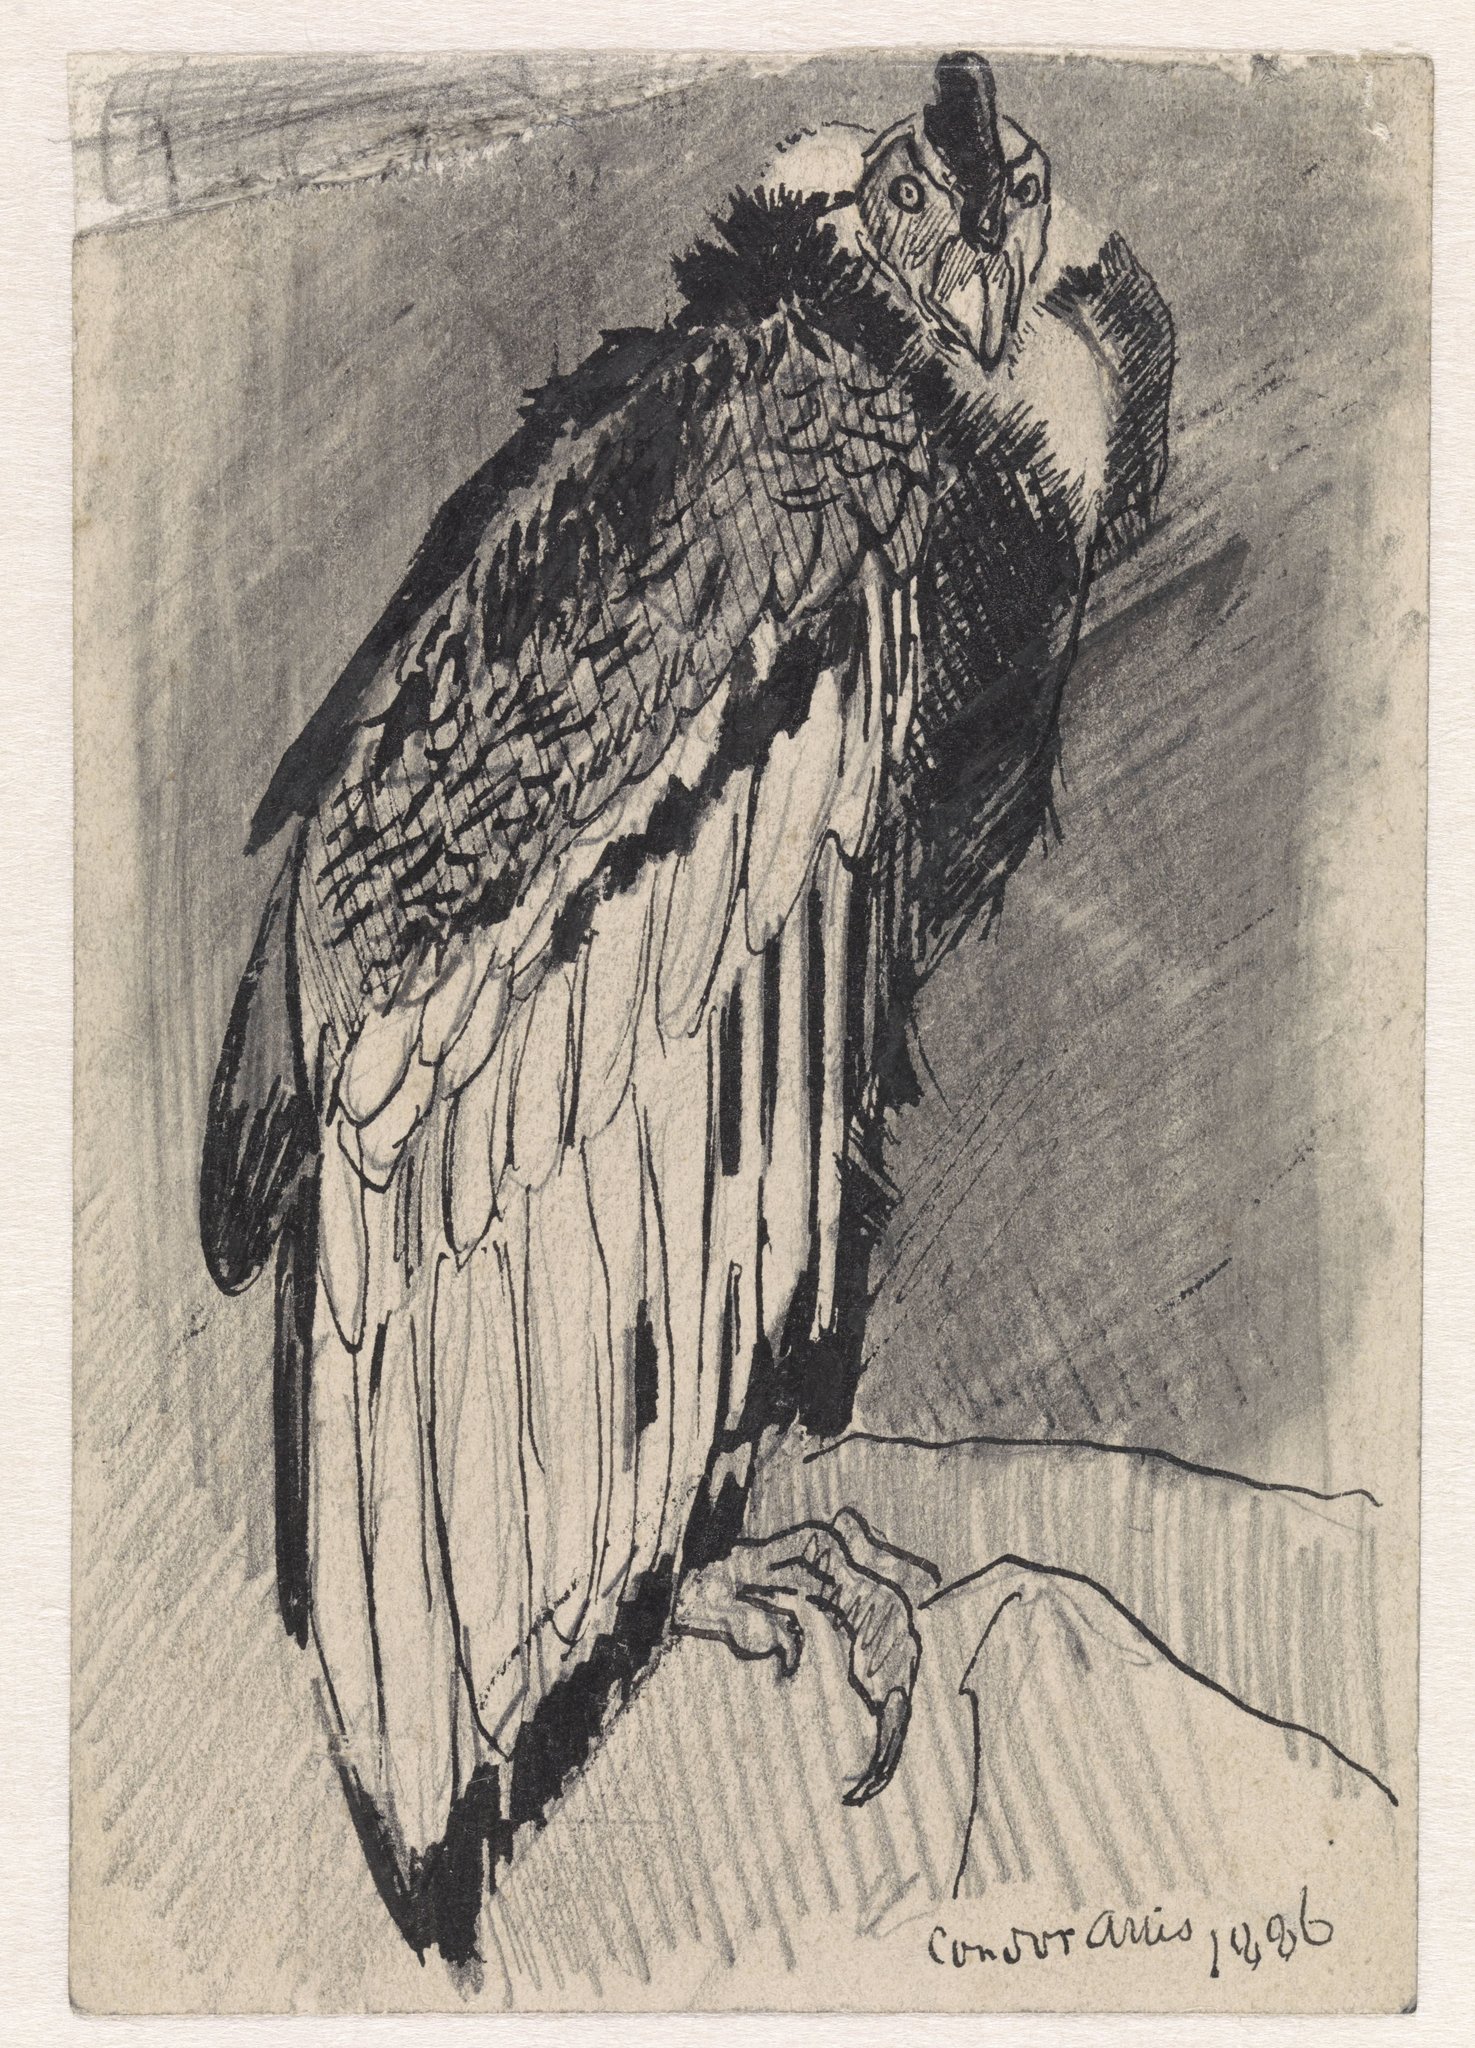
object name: drawing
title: Zittende condor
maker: jan van essen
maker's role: draughtsman, print maker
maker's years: 1854-1936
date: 1886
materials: ink, paper, pencil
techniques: brush, pen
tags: predatory birds: condor